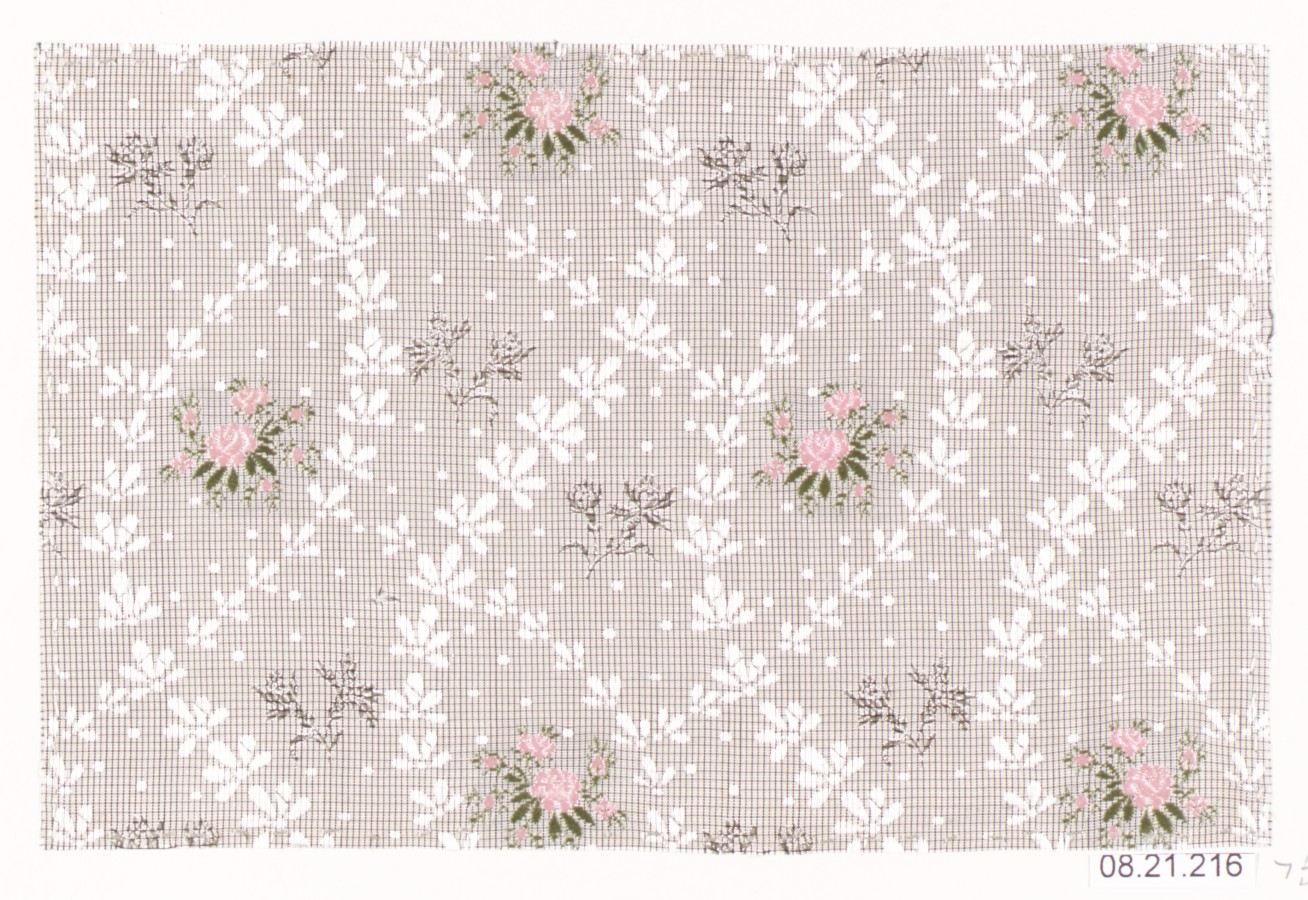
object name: textile sample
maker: Anonymous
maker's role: designer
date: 1900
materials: silk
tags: flowers